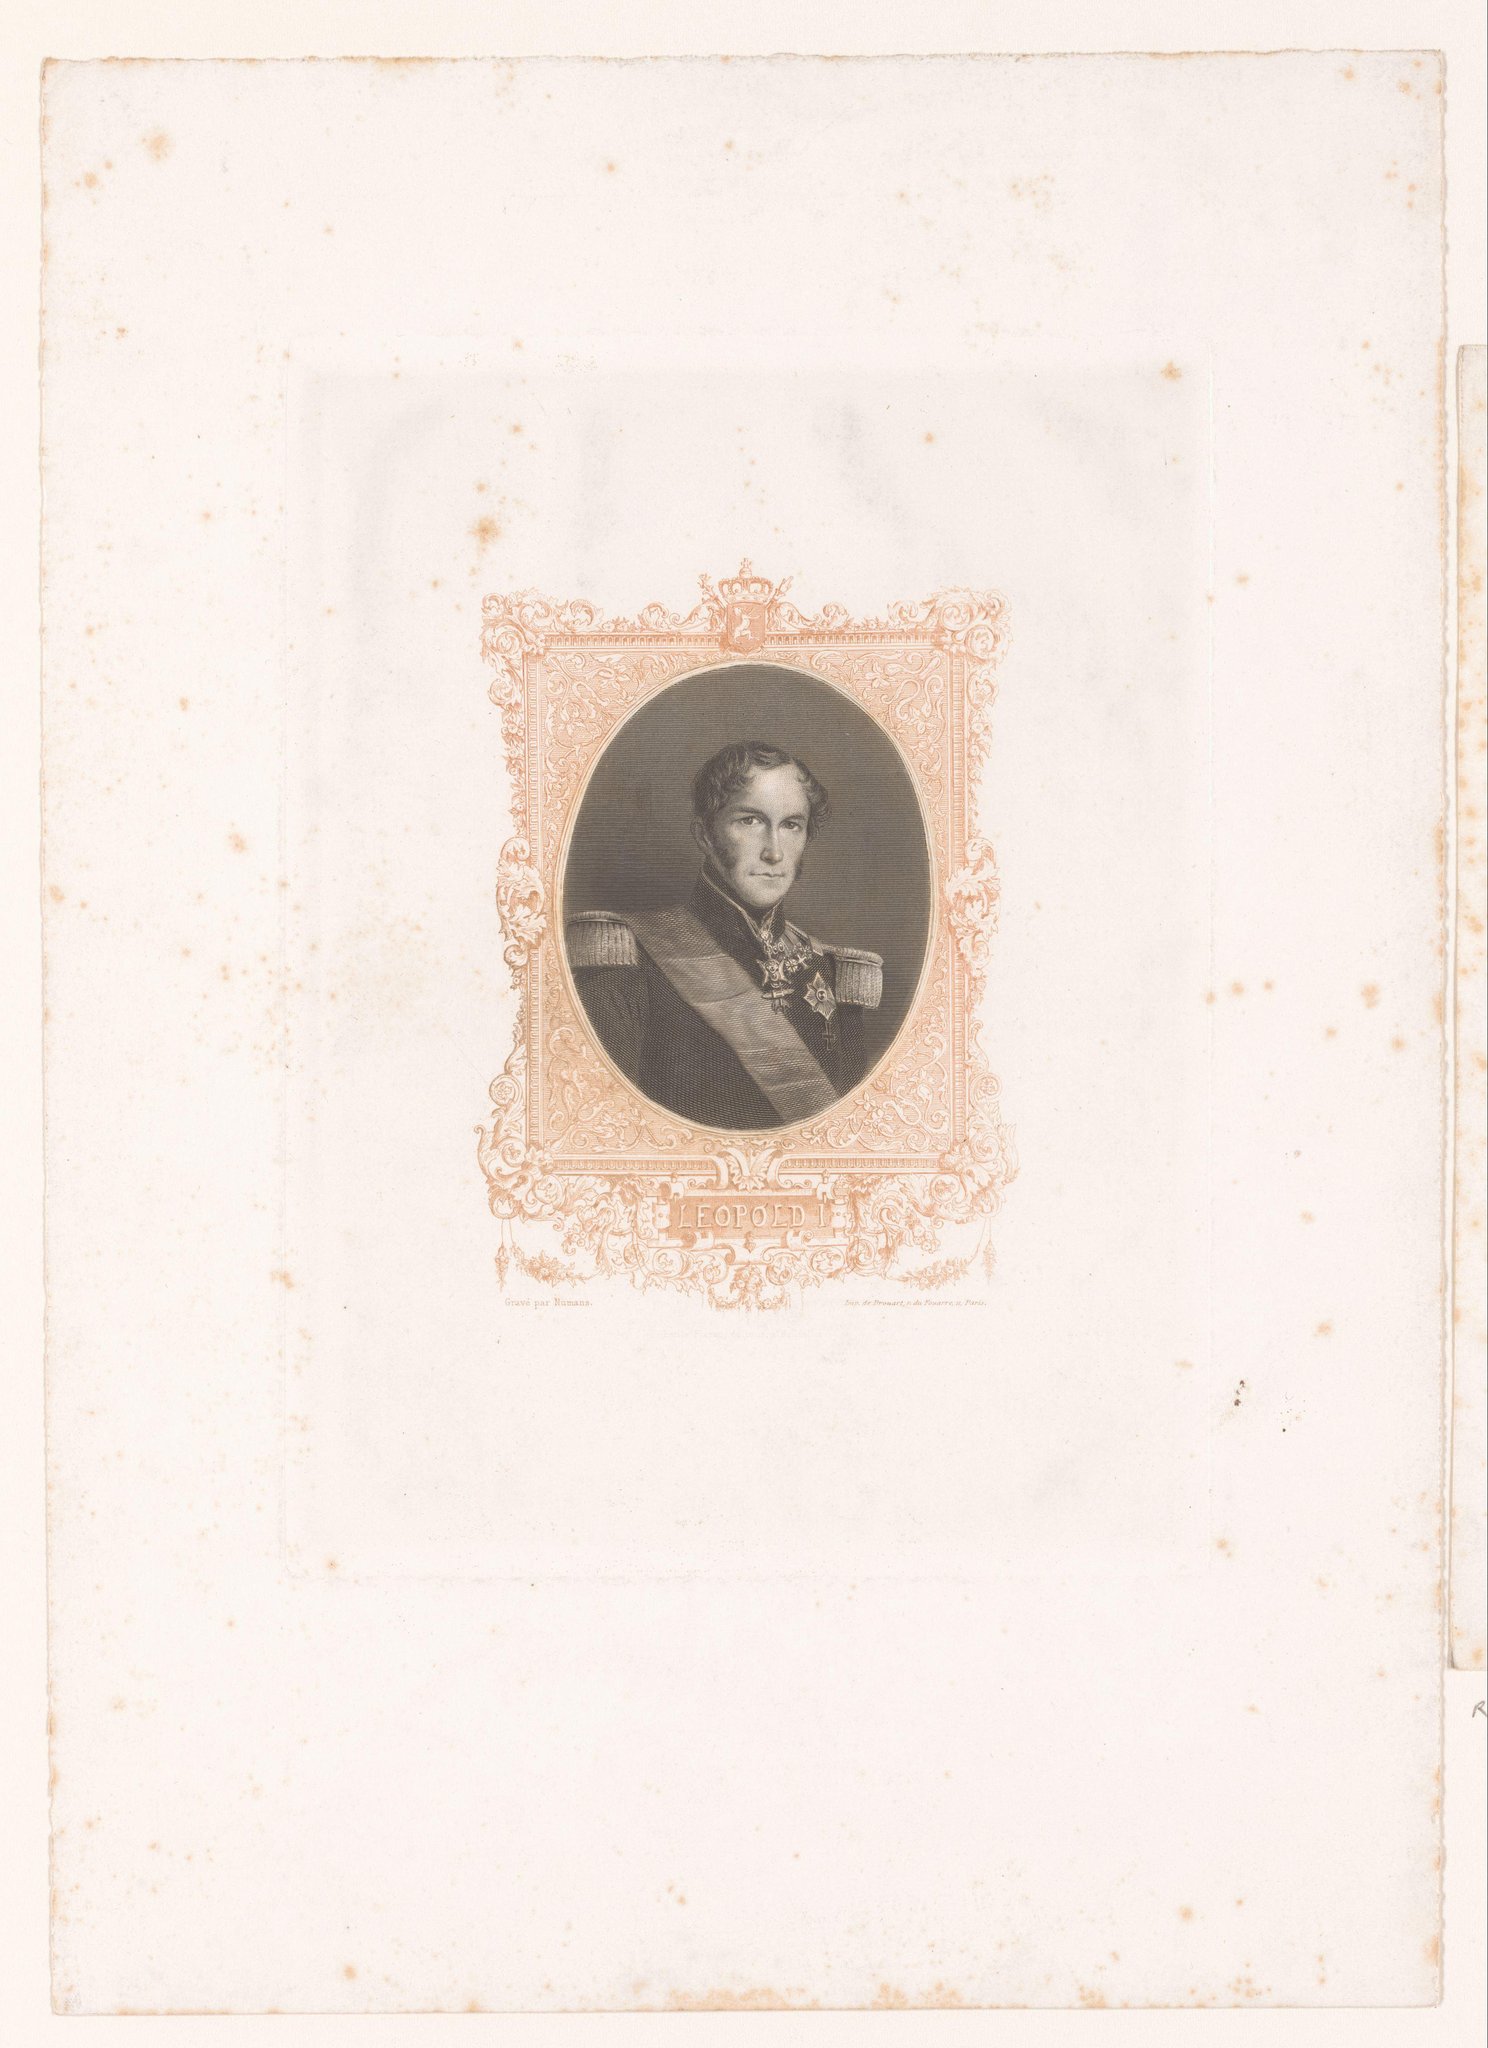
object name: print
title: Portret van Leopold I van België met ornamenteel kader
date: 1833-1880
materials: paper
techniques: engraving, etching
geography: paris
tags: laeken, leopold i (koning der belgen), adult man, historical persons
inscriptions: collector's mark: Lugt 2228, mark: ‘Emile [Flatan] editeur a Bruxelles.’